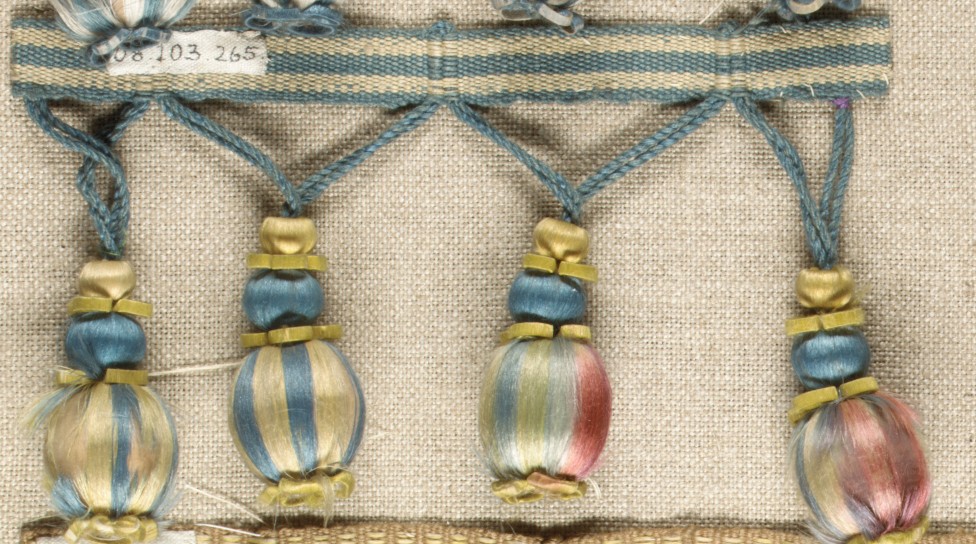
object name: fringe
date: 1801-1900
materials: cotton, silk